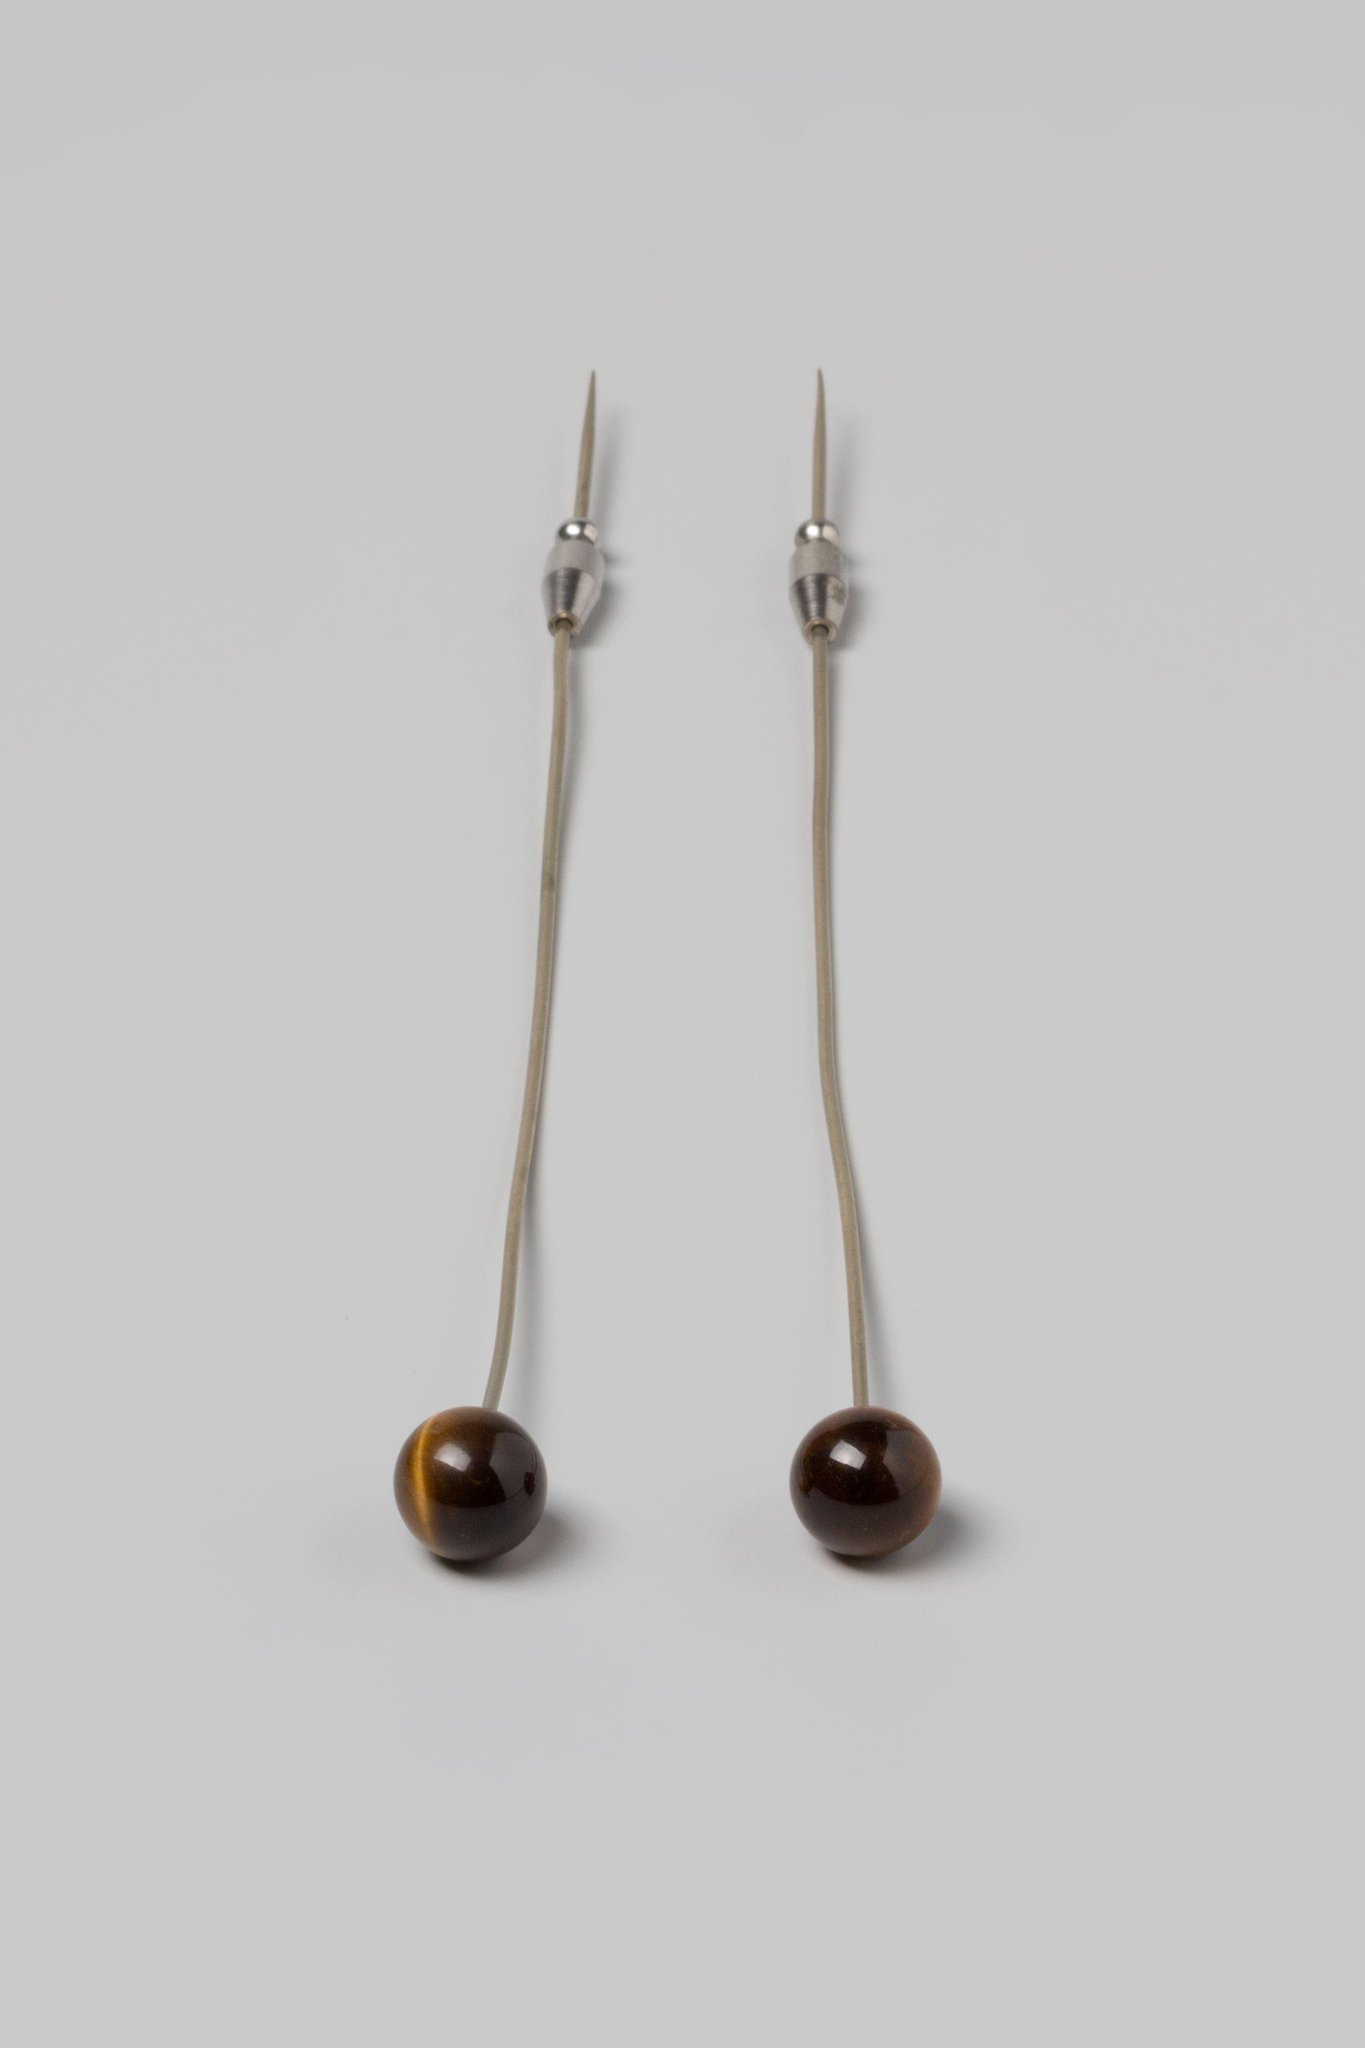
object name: hatpin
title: Hoedenpen met ronde bol van tijgeroog en pin van staal, voorzien van schuif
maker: Anonymous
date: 1920-1950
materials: steel, gemstone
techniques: grinding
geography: netherlands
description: Hoedenpen met pin van staal en ronde bol van tijgeroog.